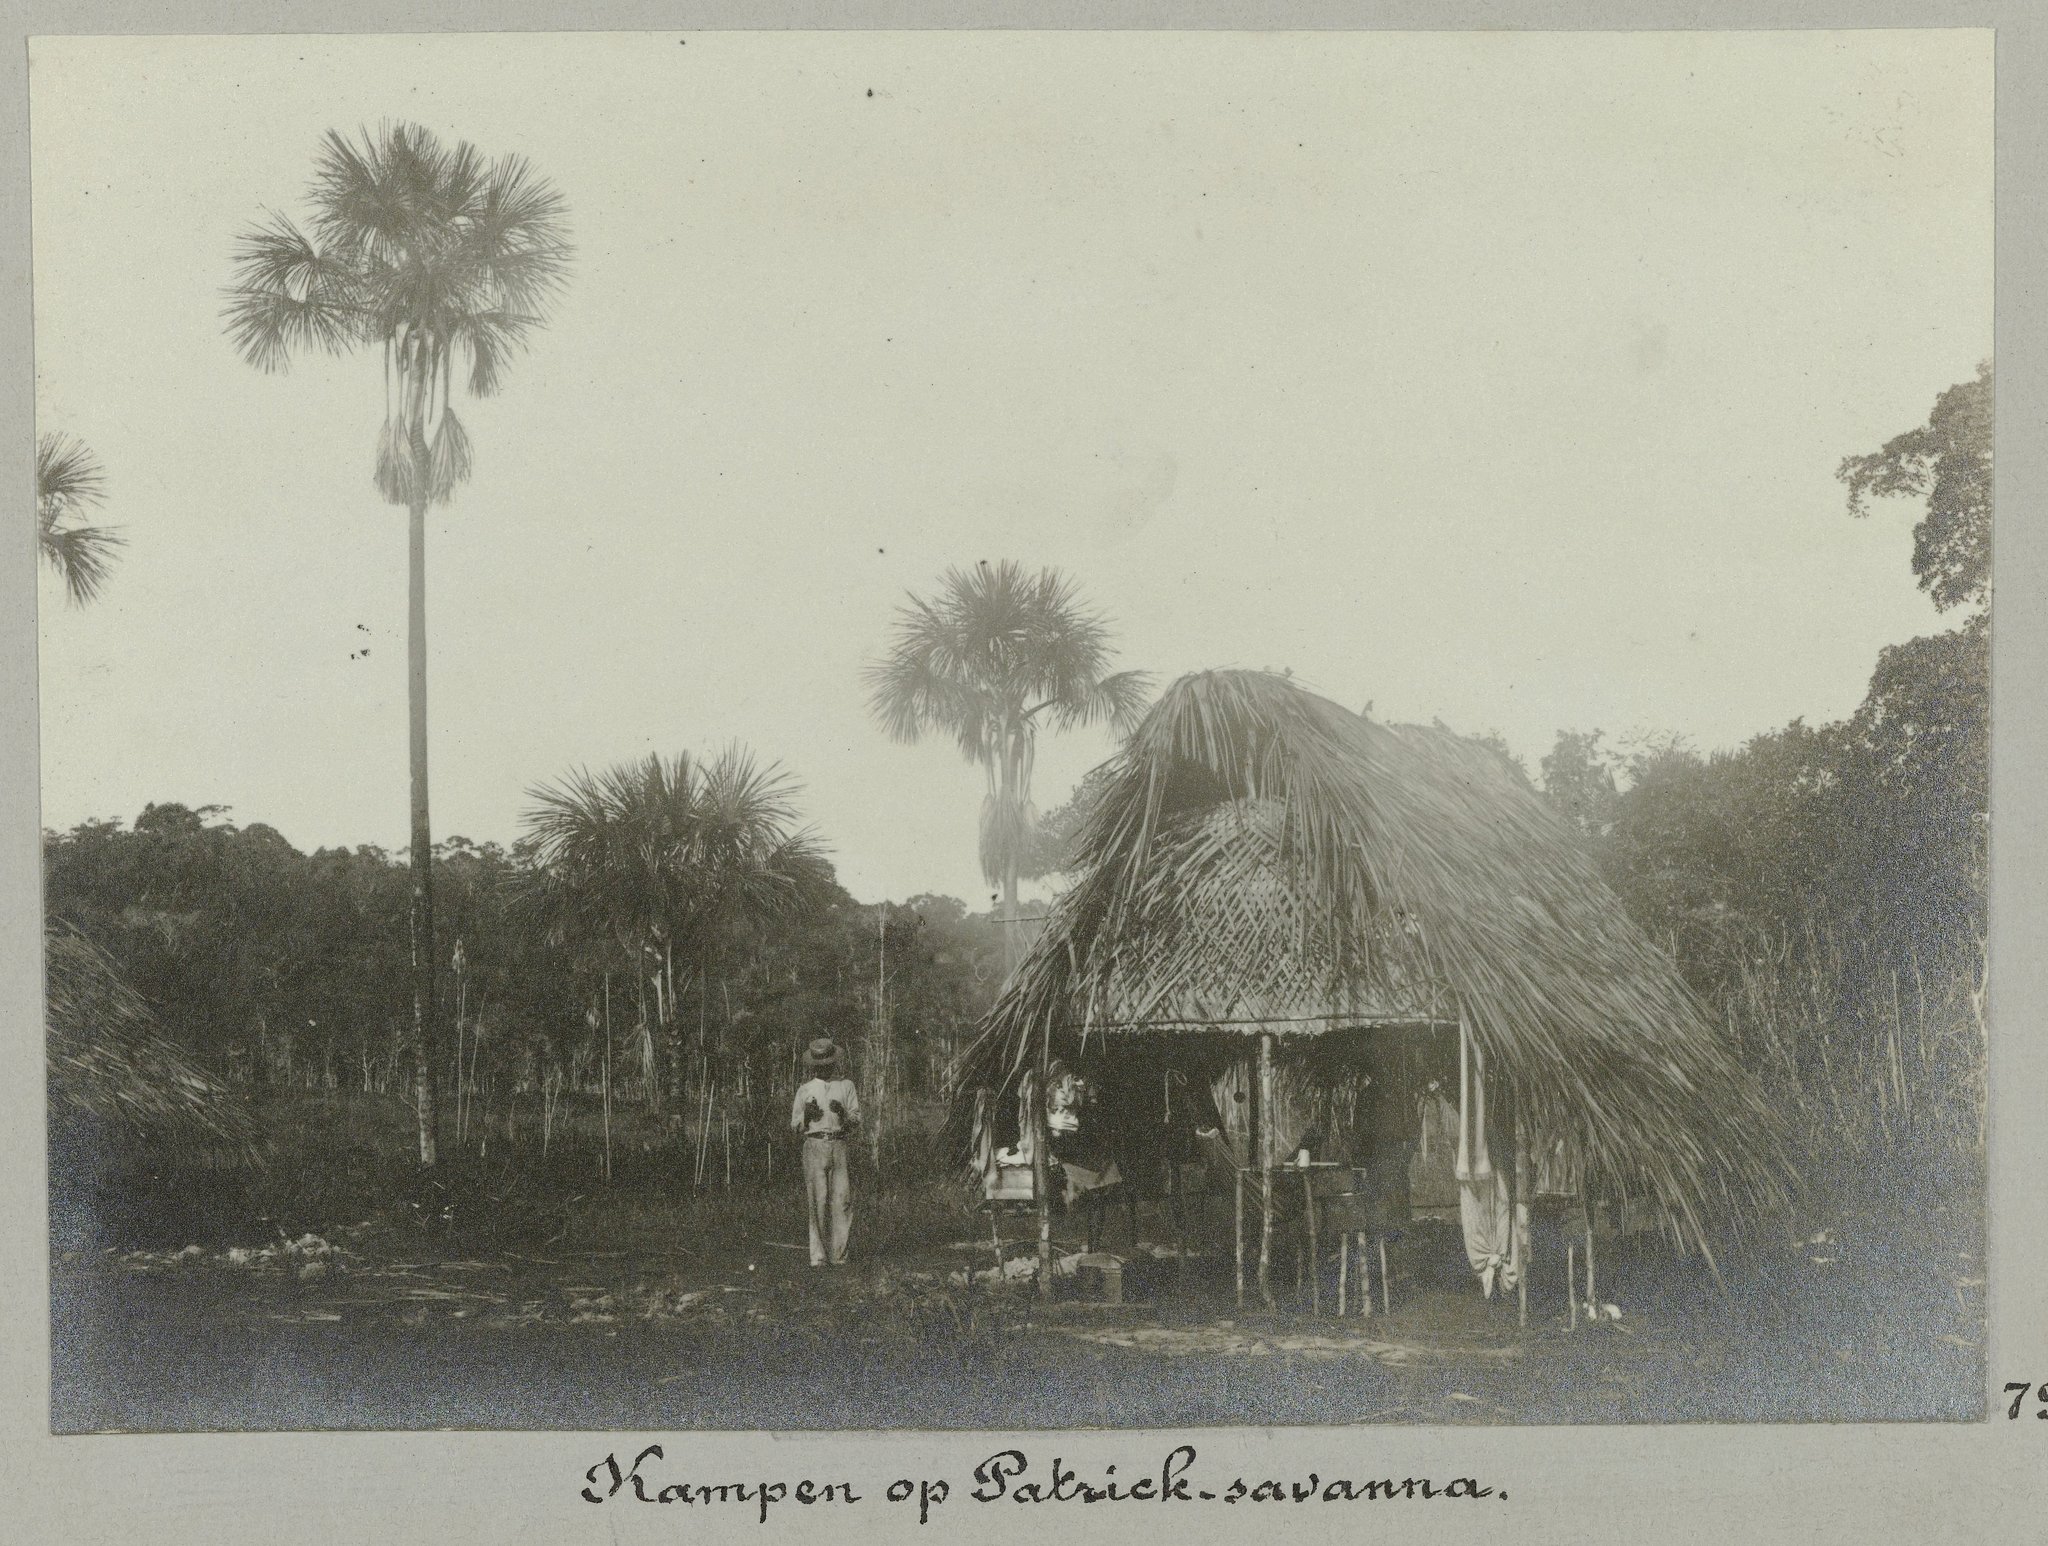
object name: photograph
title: Kampen op Patrick-savanna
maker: hendrik doijer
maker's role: engineer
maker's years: 1863-1925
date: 1903-1910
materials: photographic support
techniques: gelatin silver print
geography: suriname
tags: suriname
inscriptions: inscription: ‘79. / Kampen op Patrick-savanna.’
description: Een woning in een kamp op de Patrick-savanna. Onderdeel van het fotoalbum Souvenir de Voyage (deel 3), over het leven van de familie Doijer in en rond de plantage Ma Retraite in Suriname in de jaren 1903-1910.